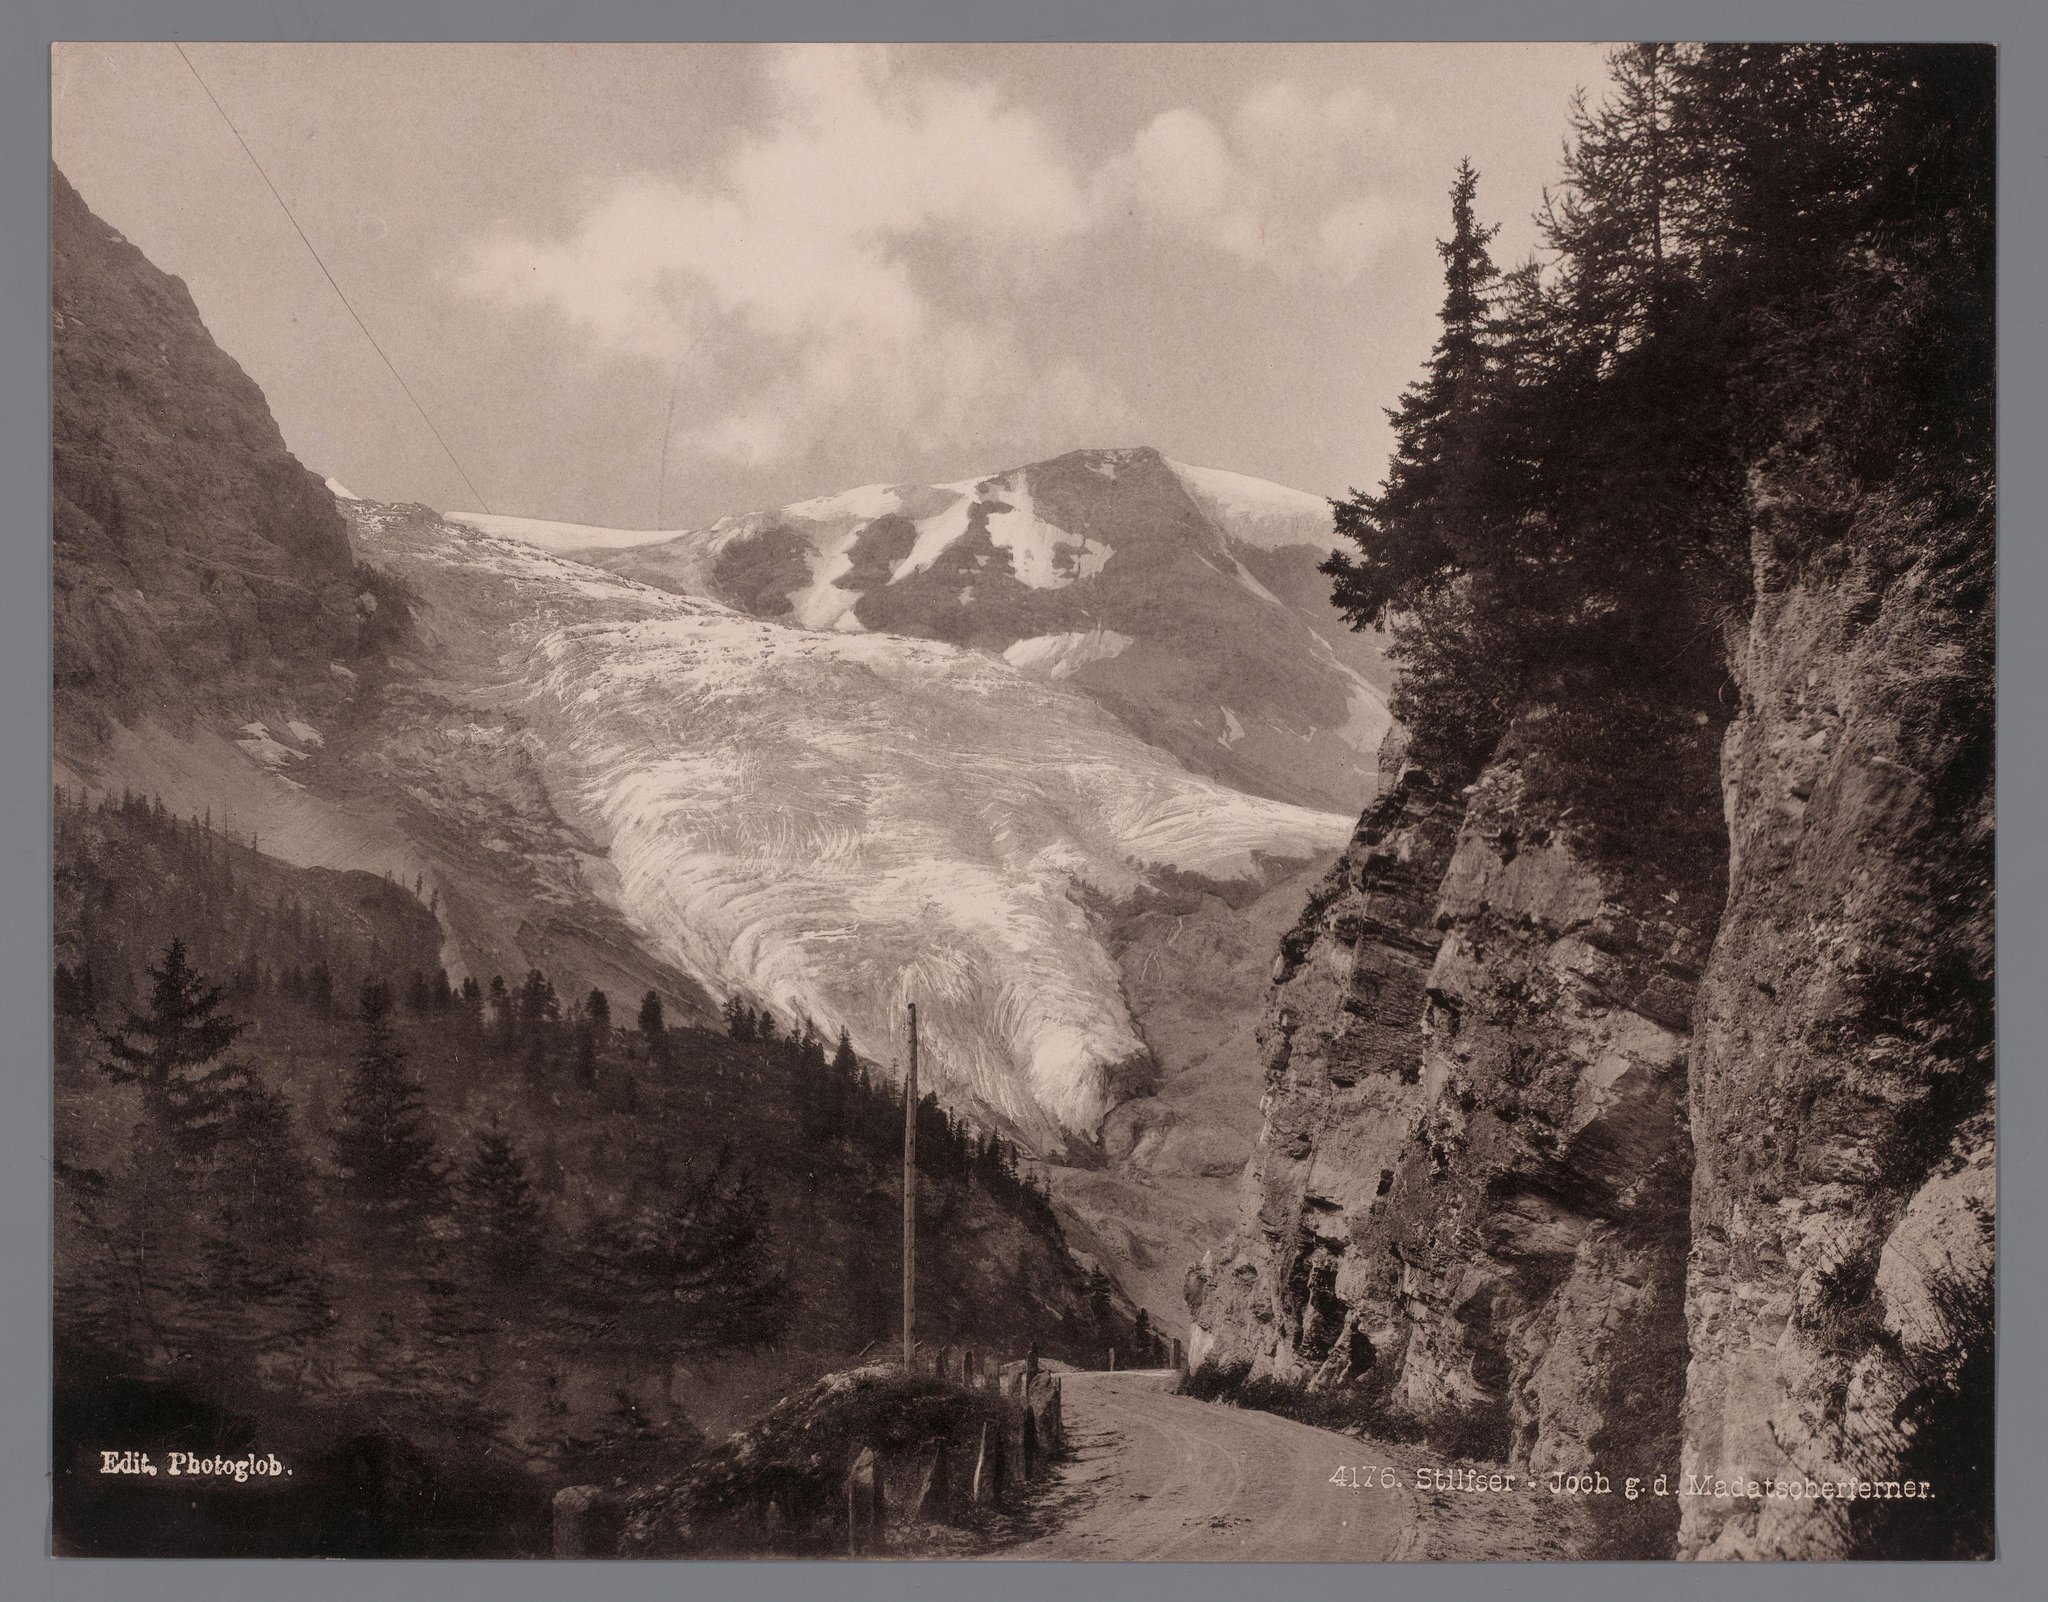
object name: photograph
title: Stelvio-pas en berg "Madatscherferner", Italië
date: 1890-1910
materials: paper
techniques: photograph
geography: switzerland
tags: italy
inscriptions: inscription: ‘F.’, inscription: ‘4176. Stilfer-Joch g.d. Madatscherferner.’, inscription: ‘Edit. Photoglob.’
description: De Stelviopas [Italiaans: Passo dello Stelvio; Duits: Stilfserjoch) is een bergpas in de Italiaanse Alpen.